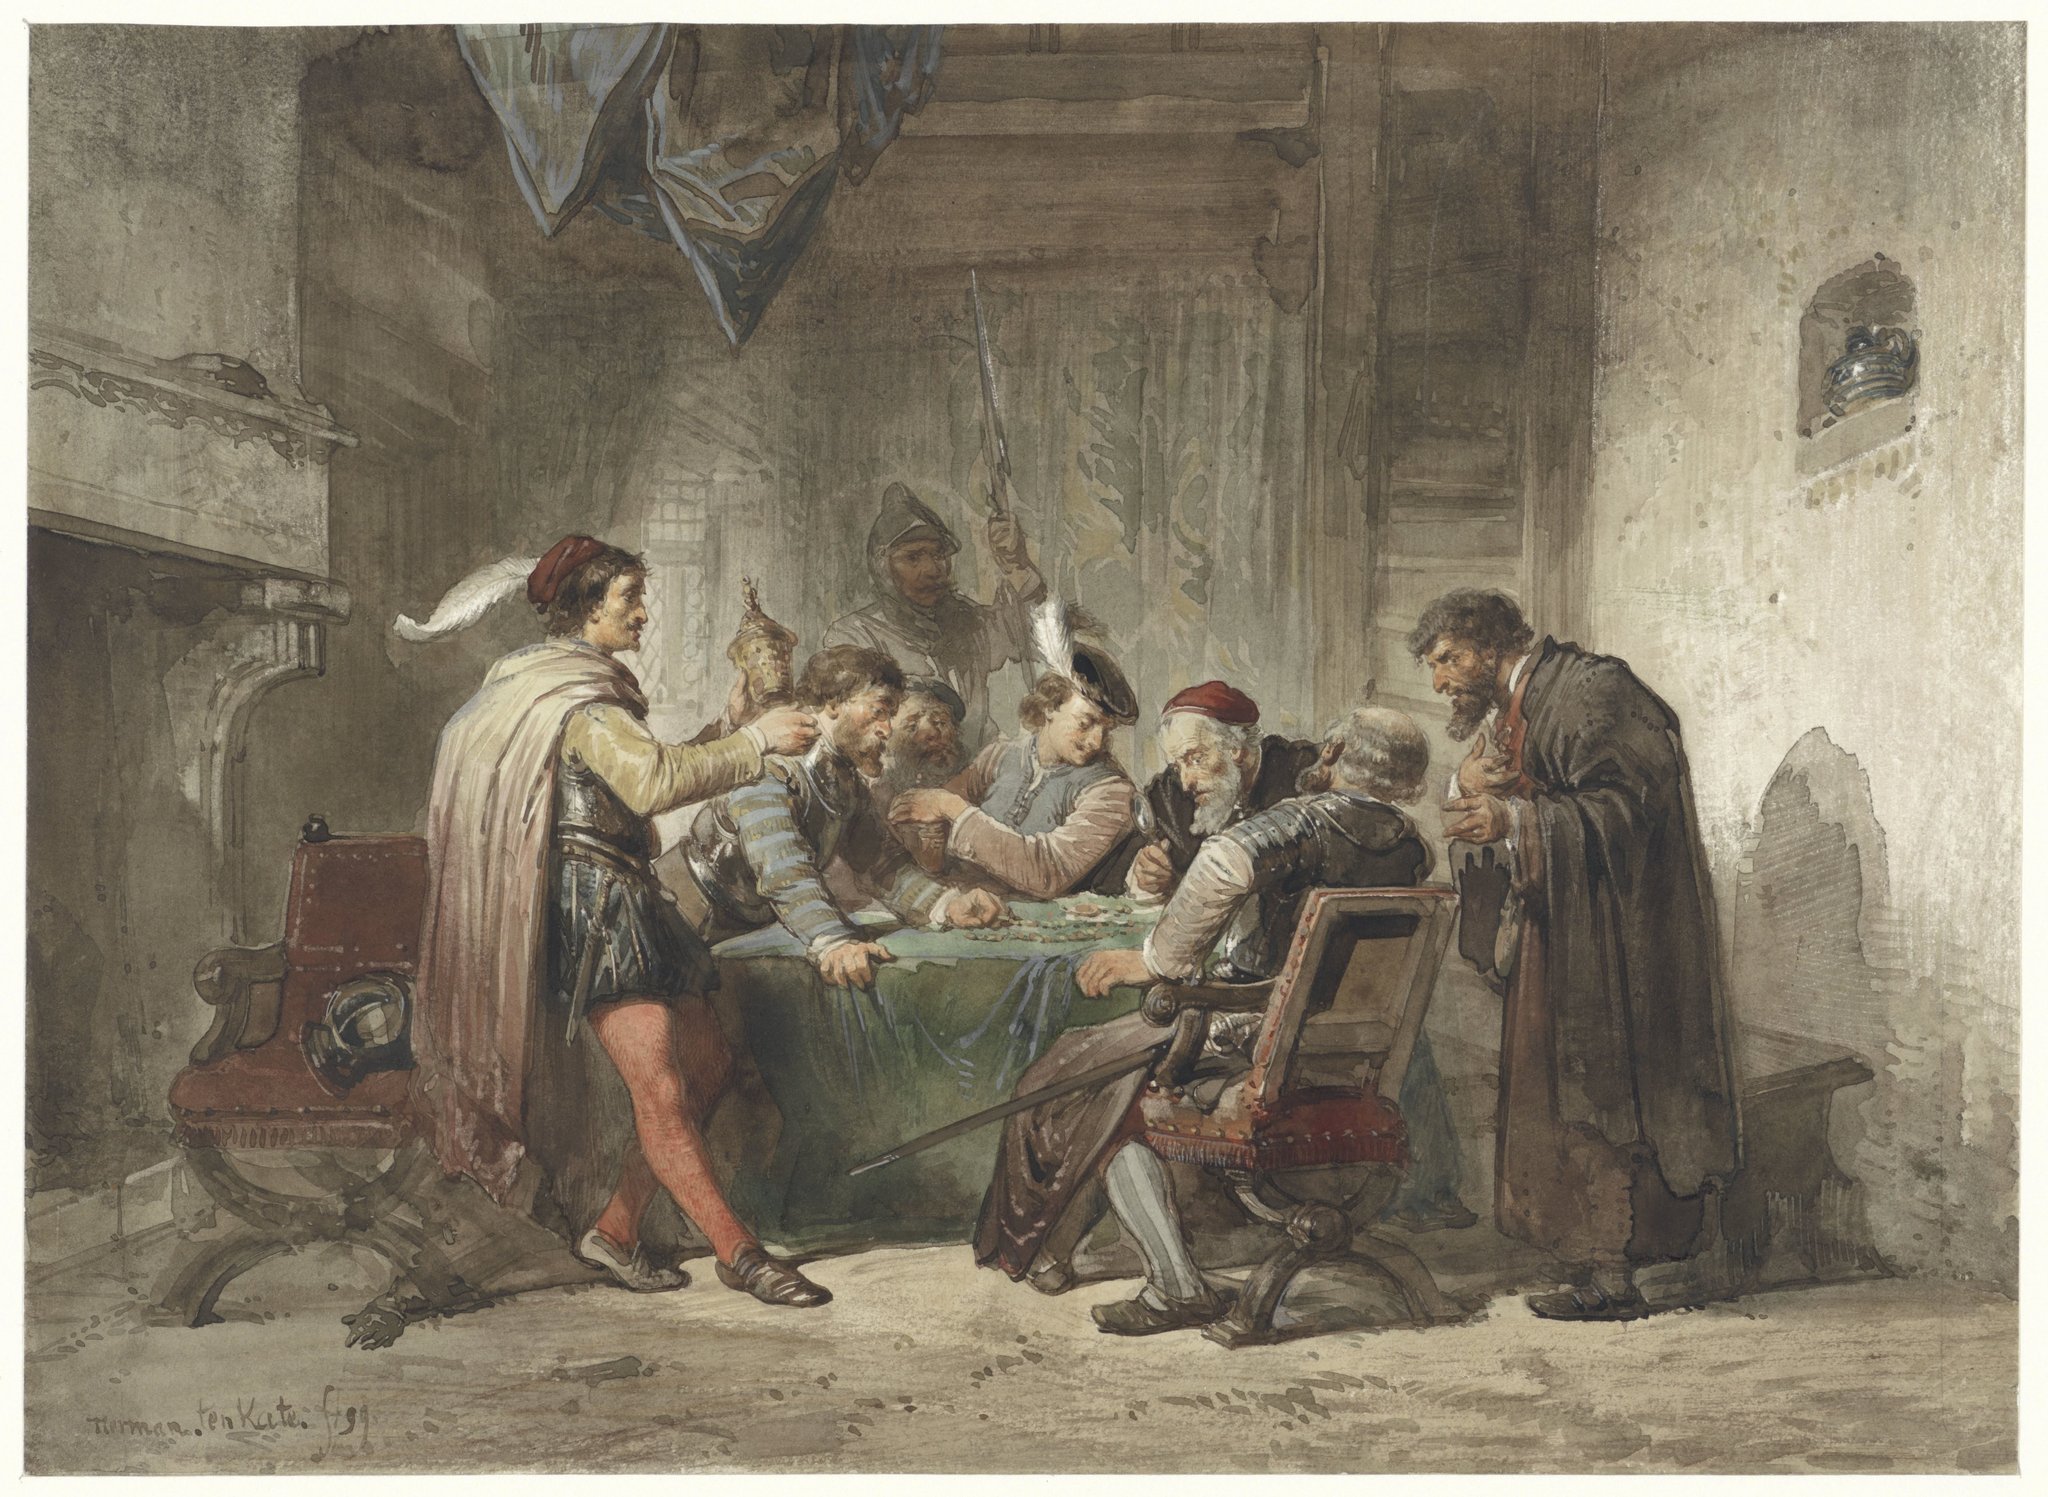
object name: watercolor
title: Het verkopen van de buit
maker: herman frederik carel ten kate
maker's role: draughtsman, painter, print maker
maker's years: 1822-1891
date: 1859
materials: paper, watercolor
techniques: brush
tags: robber, interior of the house, booty, spoil, division of the spoils of war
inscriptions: date: ‘59 (?)’